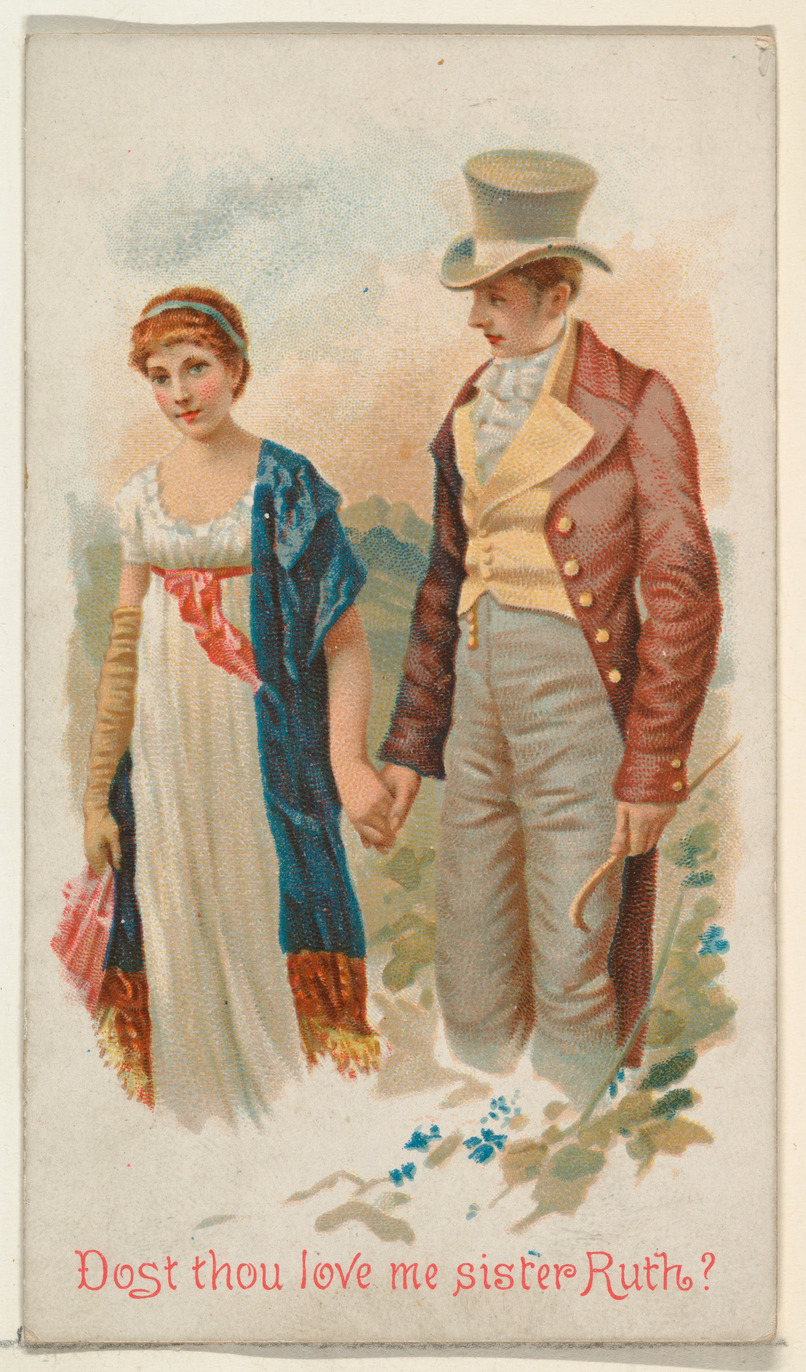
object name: print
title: Dost Thou Love Me Sister Ruth?, from the Illustrated Songs series (N116) issued by W. Duke, Sons & Co. to promote Honest Long Cut Tobacco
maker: w. duke, sons & co.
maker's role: publisher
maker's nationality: american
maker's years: 1870-1920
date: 1893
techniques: color lithograph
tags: men,women